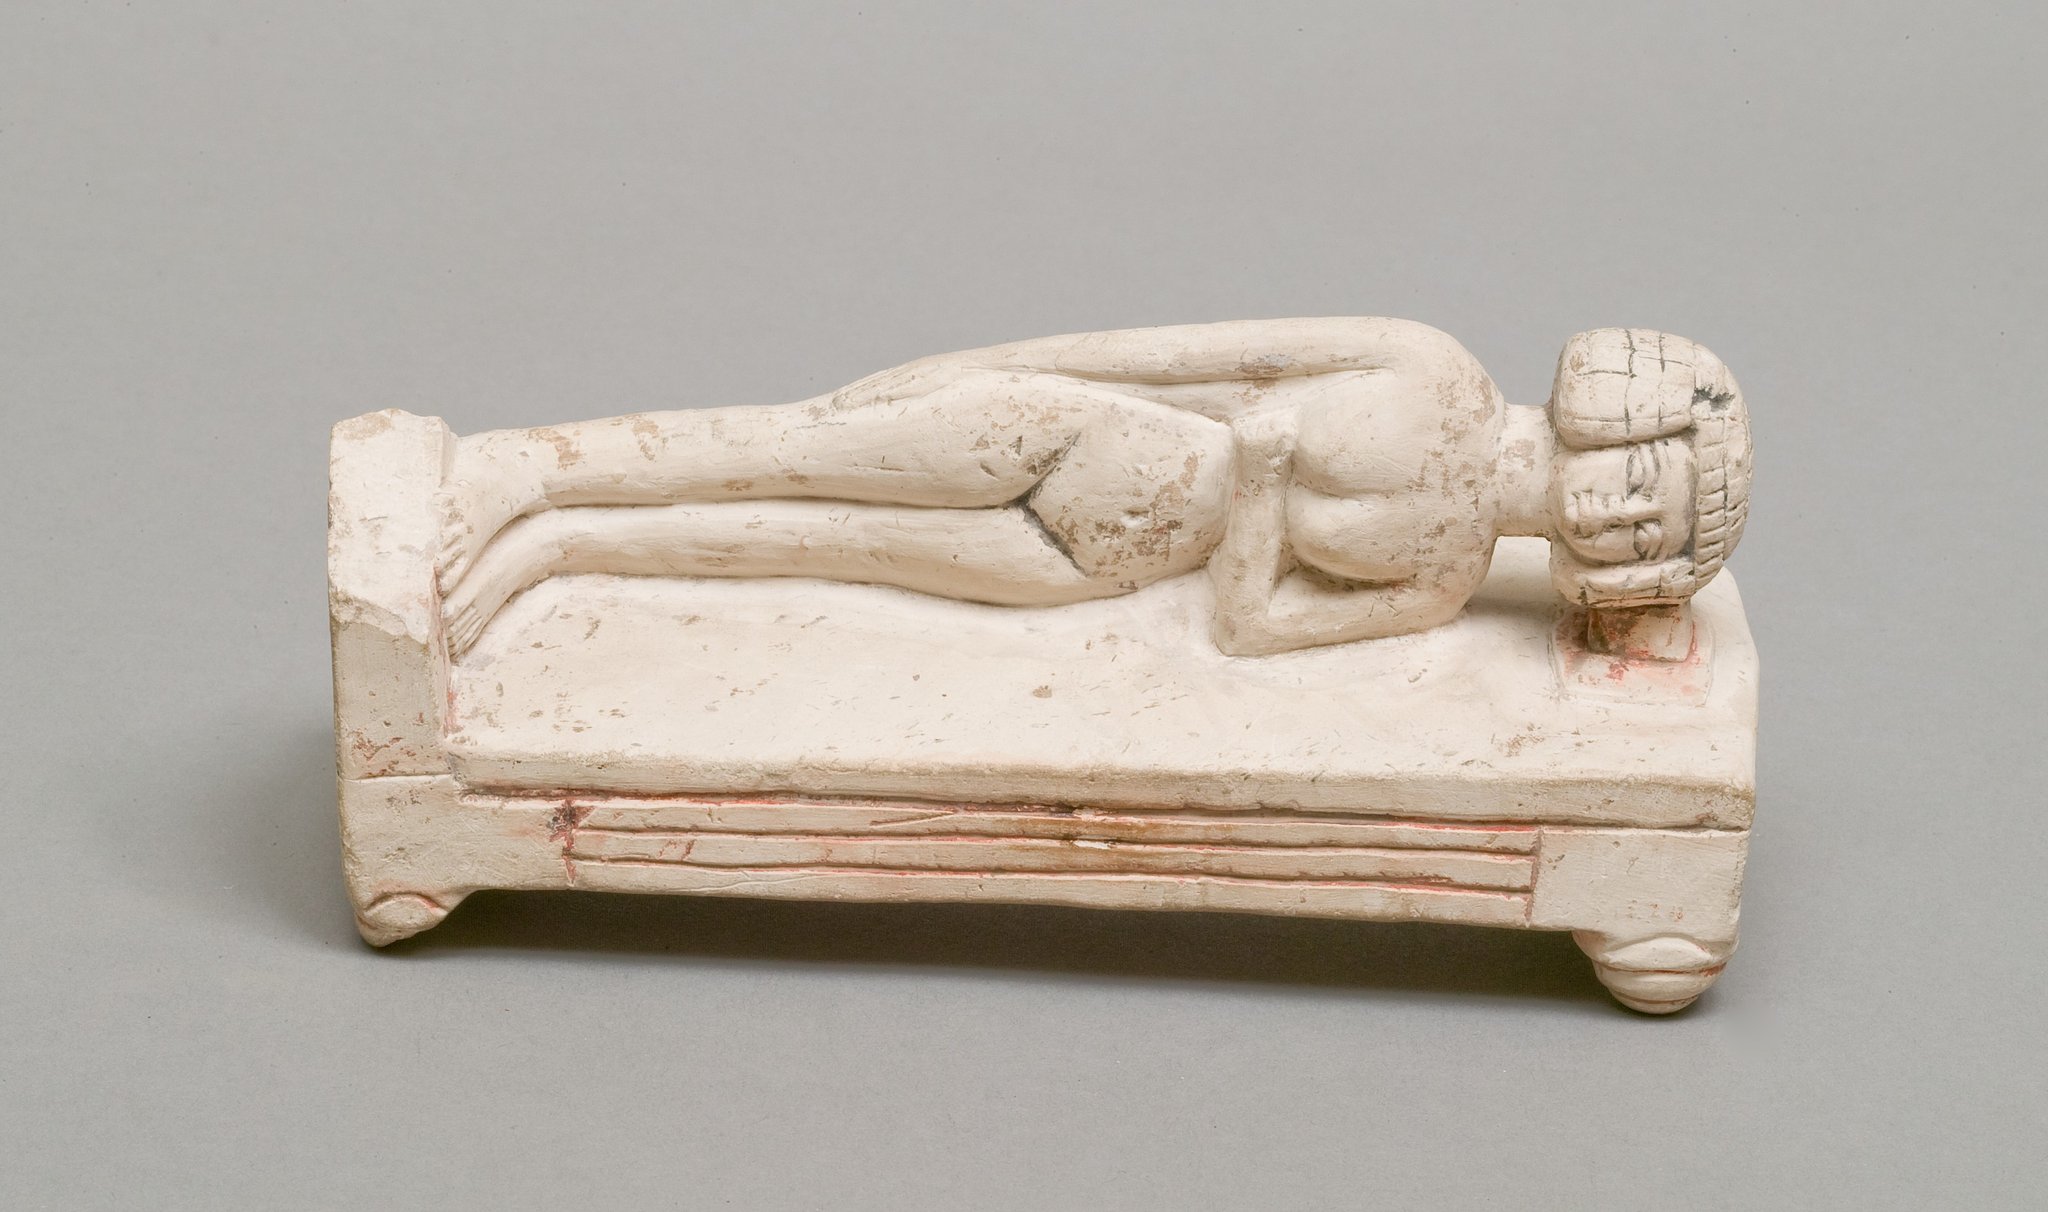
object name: bed, woman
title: Reclining female figure on a bed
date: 1550-1295 BCE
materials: limestone, paint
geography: egypt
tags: women,beds